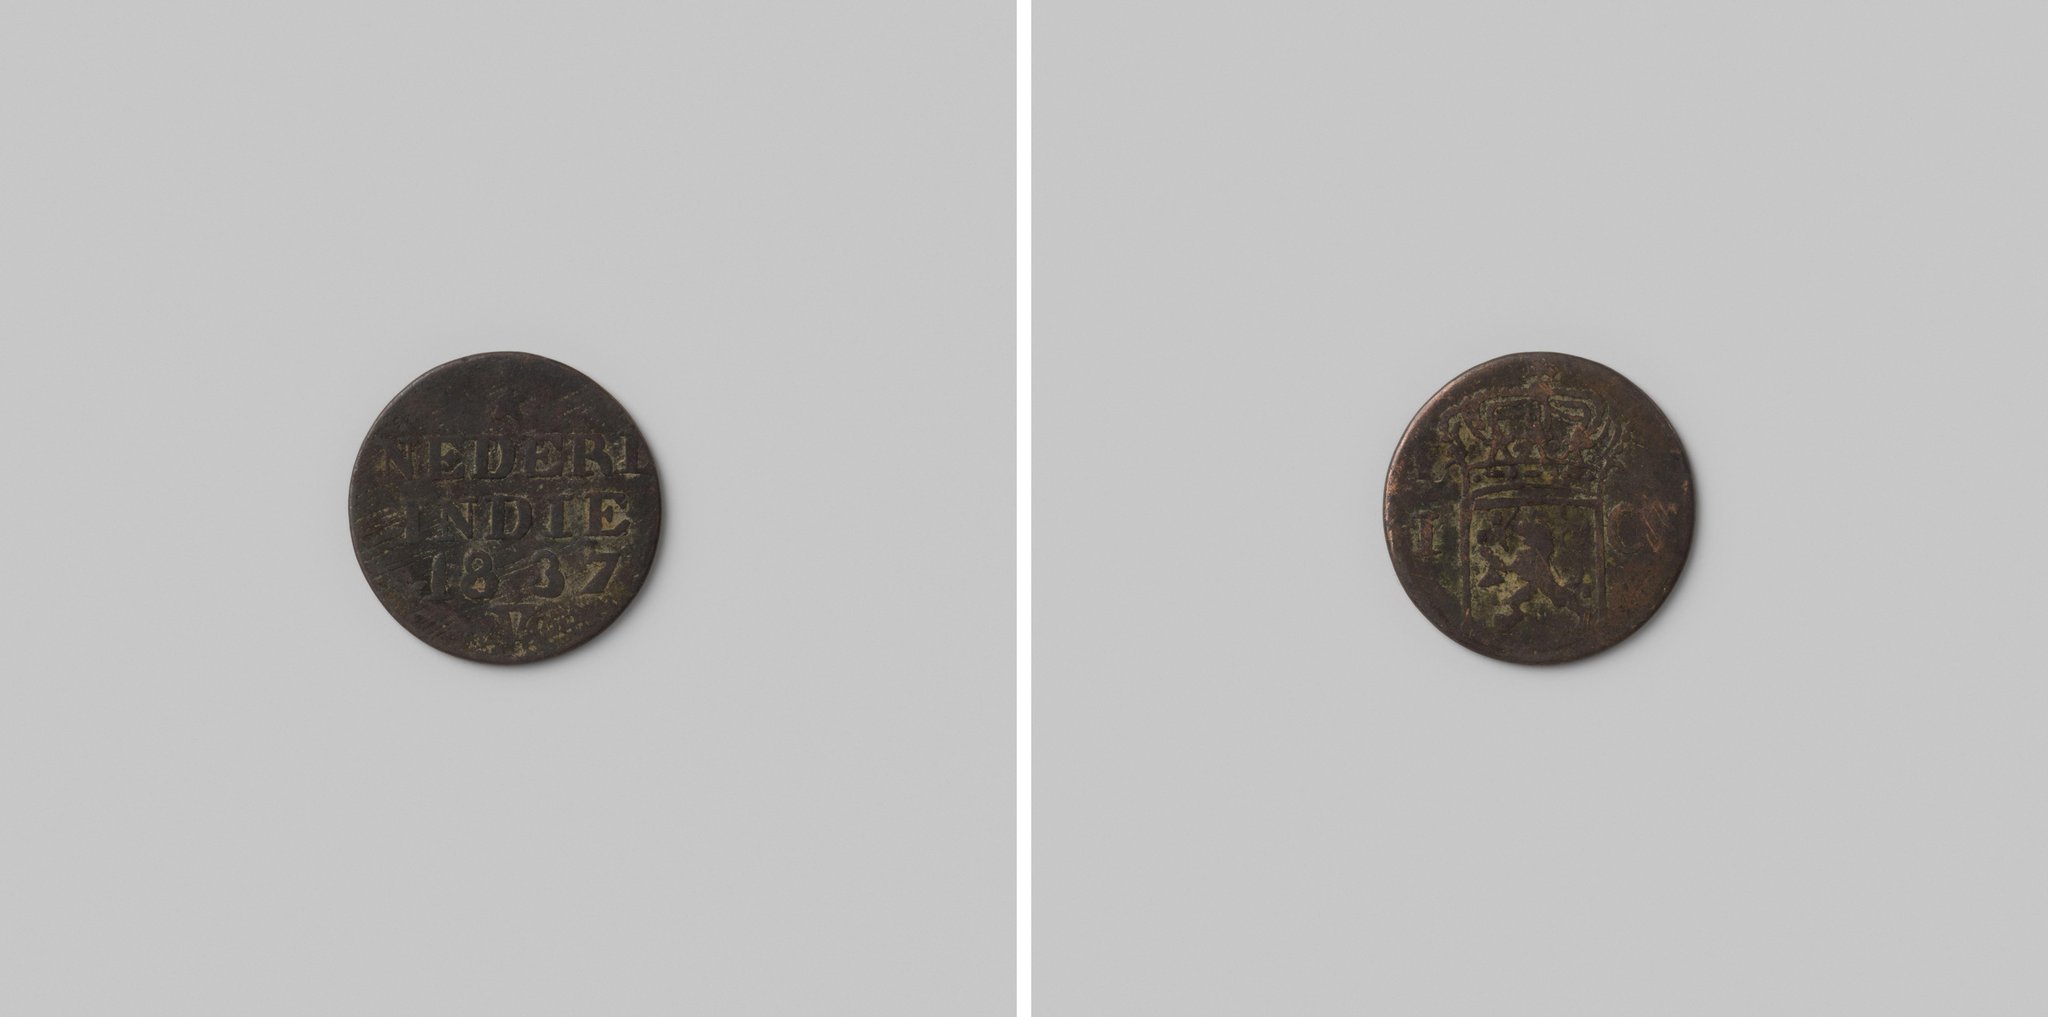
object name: coin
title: Koperen 1 cent muntje uit 1837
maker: Anonymous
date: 1837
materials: copper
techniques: striking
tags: dutch east indies, the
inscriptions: inscription: ‘Jacques Schulman / Numismaat / Keizersgracht 448 / Amsterdam-C.’, inscription: ‘NEDERL / INDIE / 1837 / V’, inscription: ‘1 C’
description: Koperen muntje van 1 cent uit 1837. Voorzijde: opschrift. Keerzijde: gekroond wapen met leeuw erin. Links van het wapen een 1 en rechts van het wapen een C. Het muntje zit in een envelopje met opschrift.